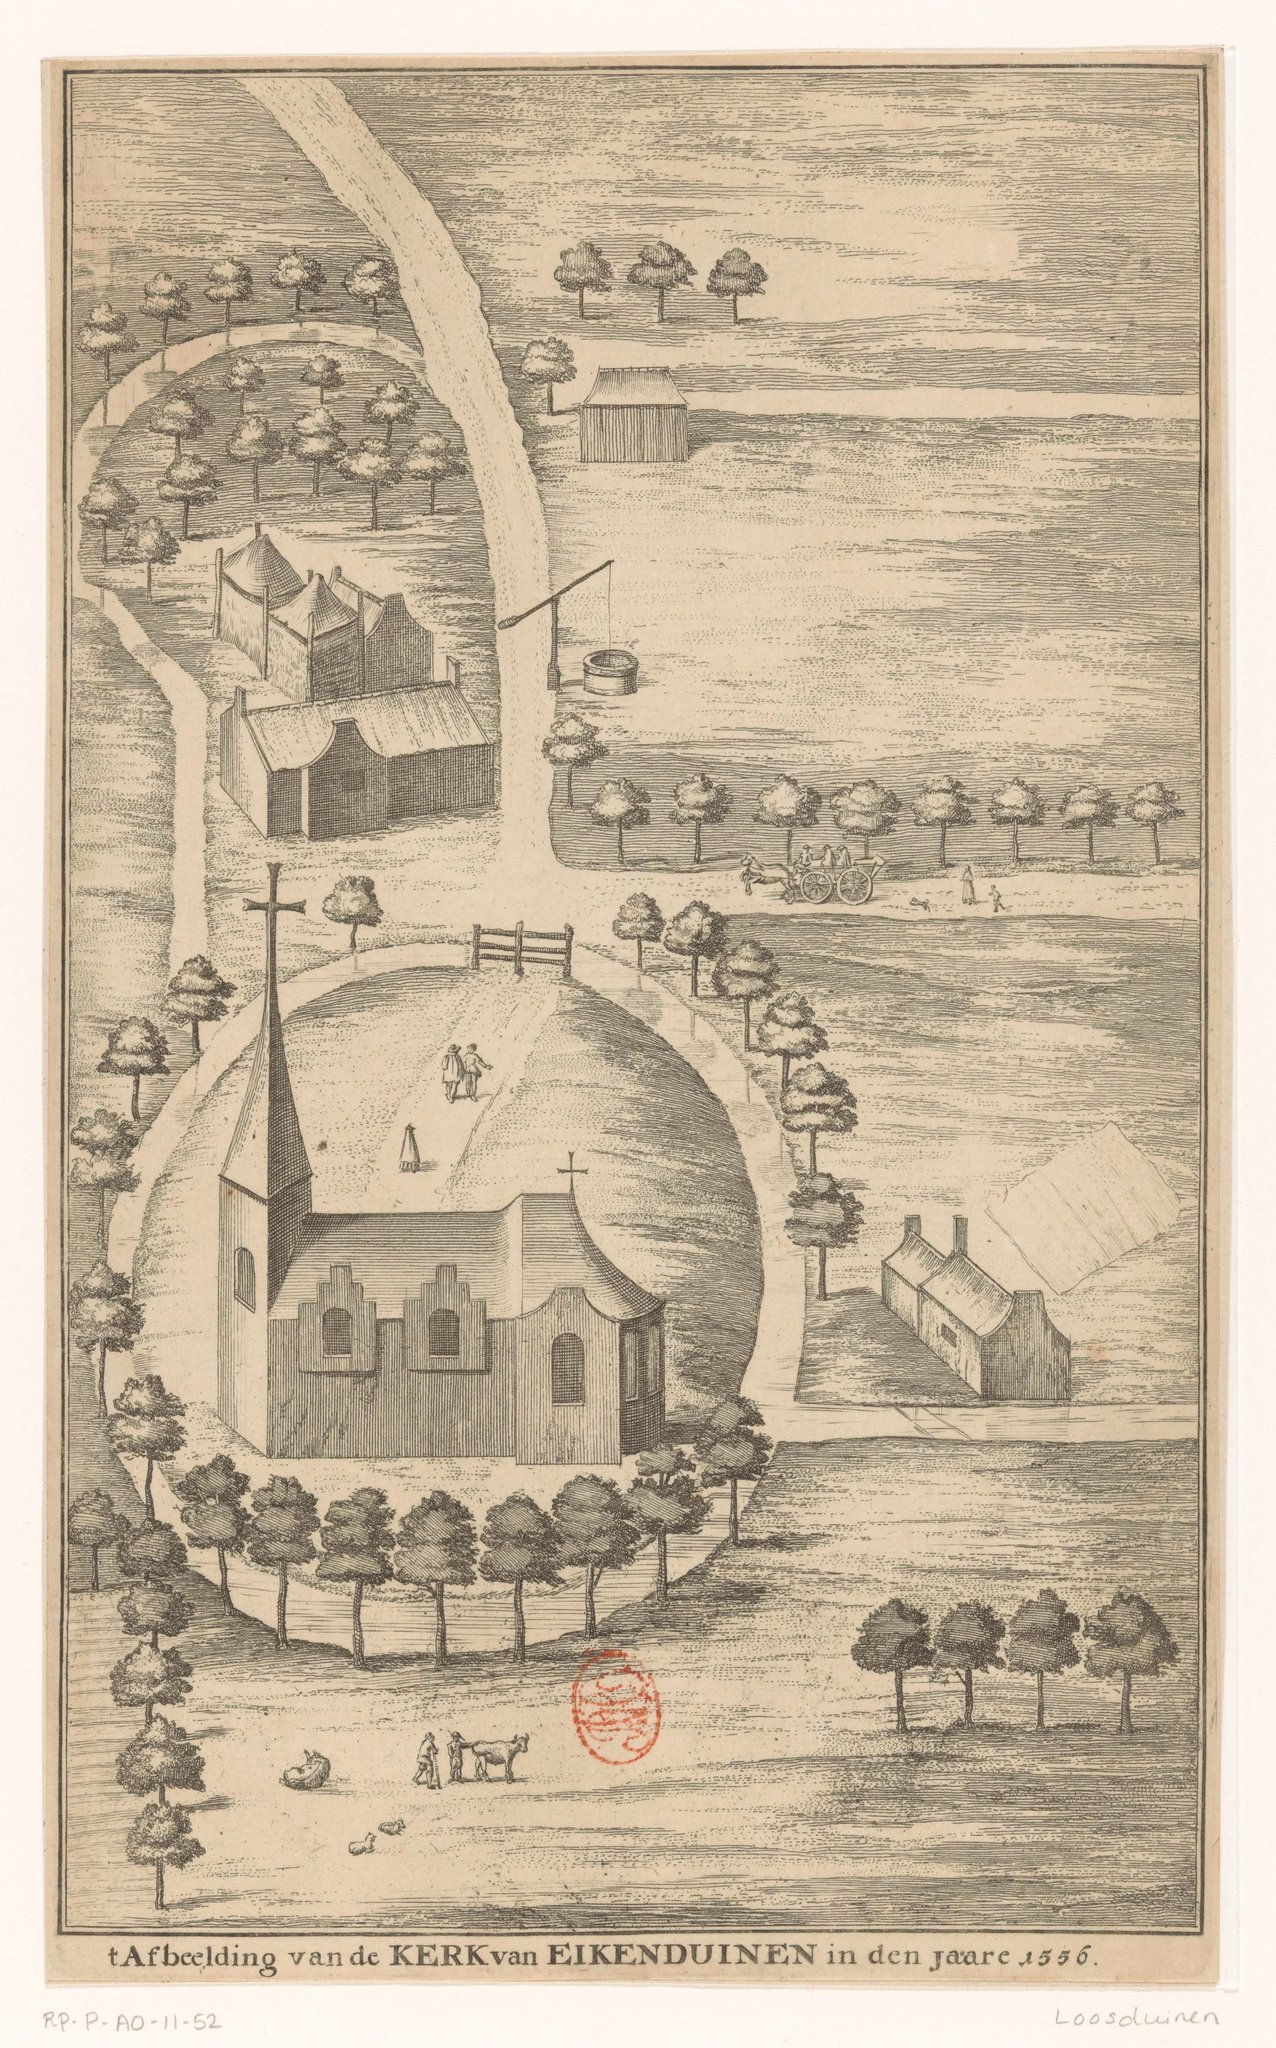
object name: book illustration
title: Gezicht op de kerk van Eik en Duinen, 1556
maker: Anonymous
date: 1730-1736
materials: paper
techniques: engraving, etching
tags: church (exterior), bird's eye view ~ representation of building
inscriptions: collector's mark: Lugt 195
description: Gezicht op de kerk van Eik en Duinen, een voormalig gehucht gelegen in de duinen tussen Loosduinen en Den Haag, in vogelvluchtperspectief in het jaar 1556. De kerk werd in 1580 gesloopt.